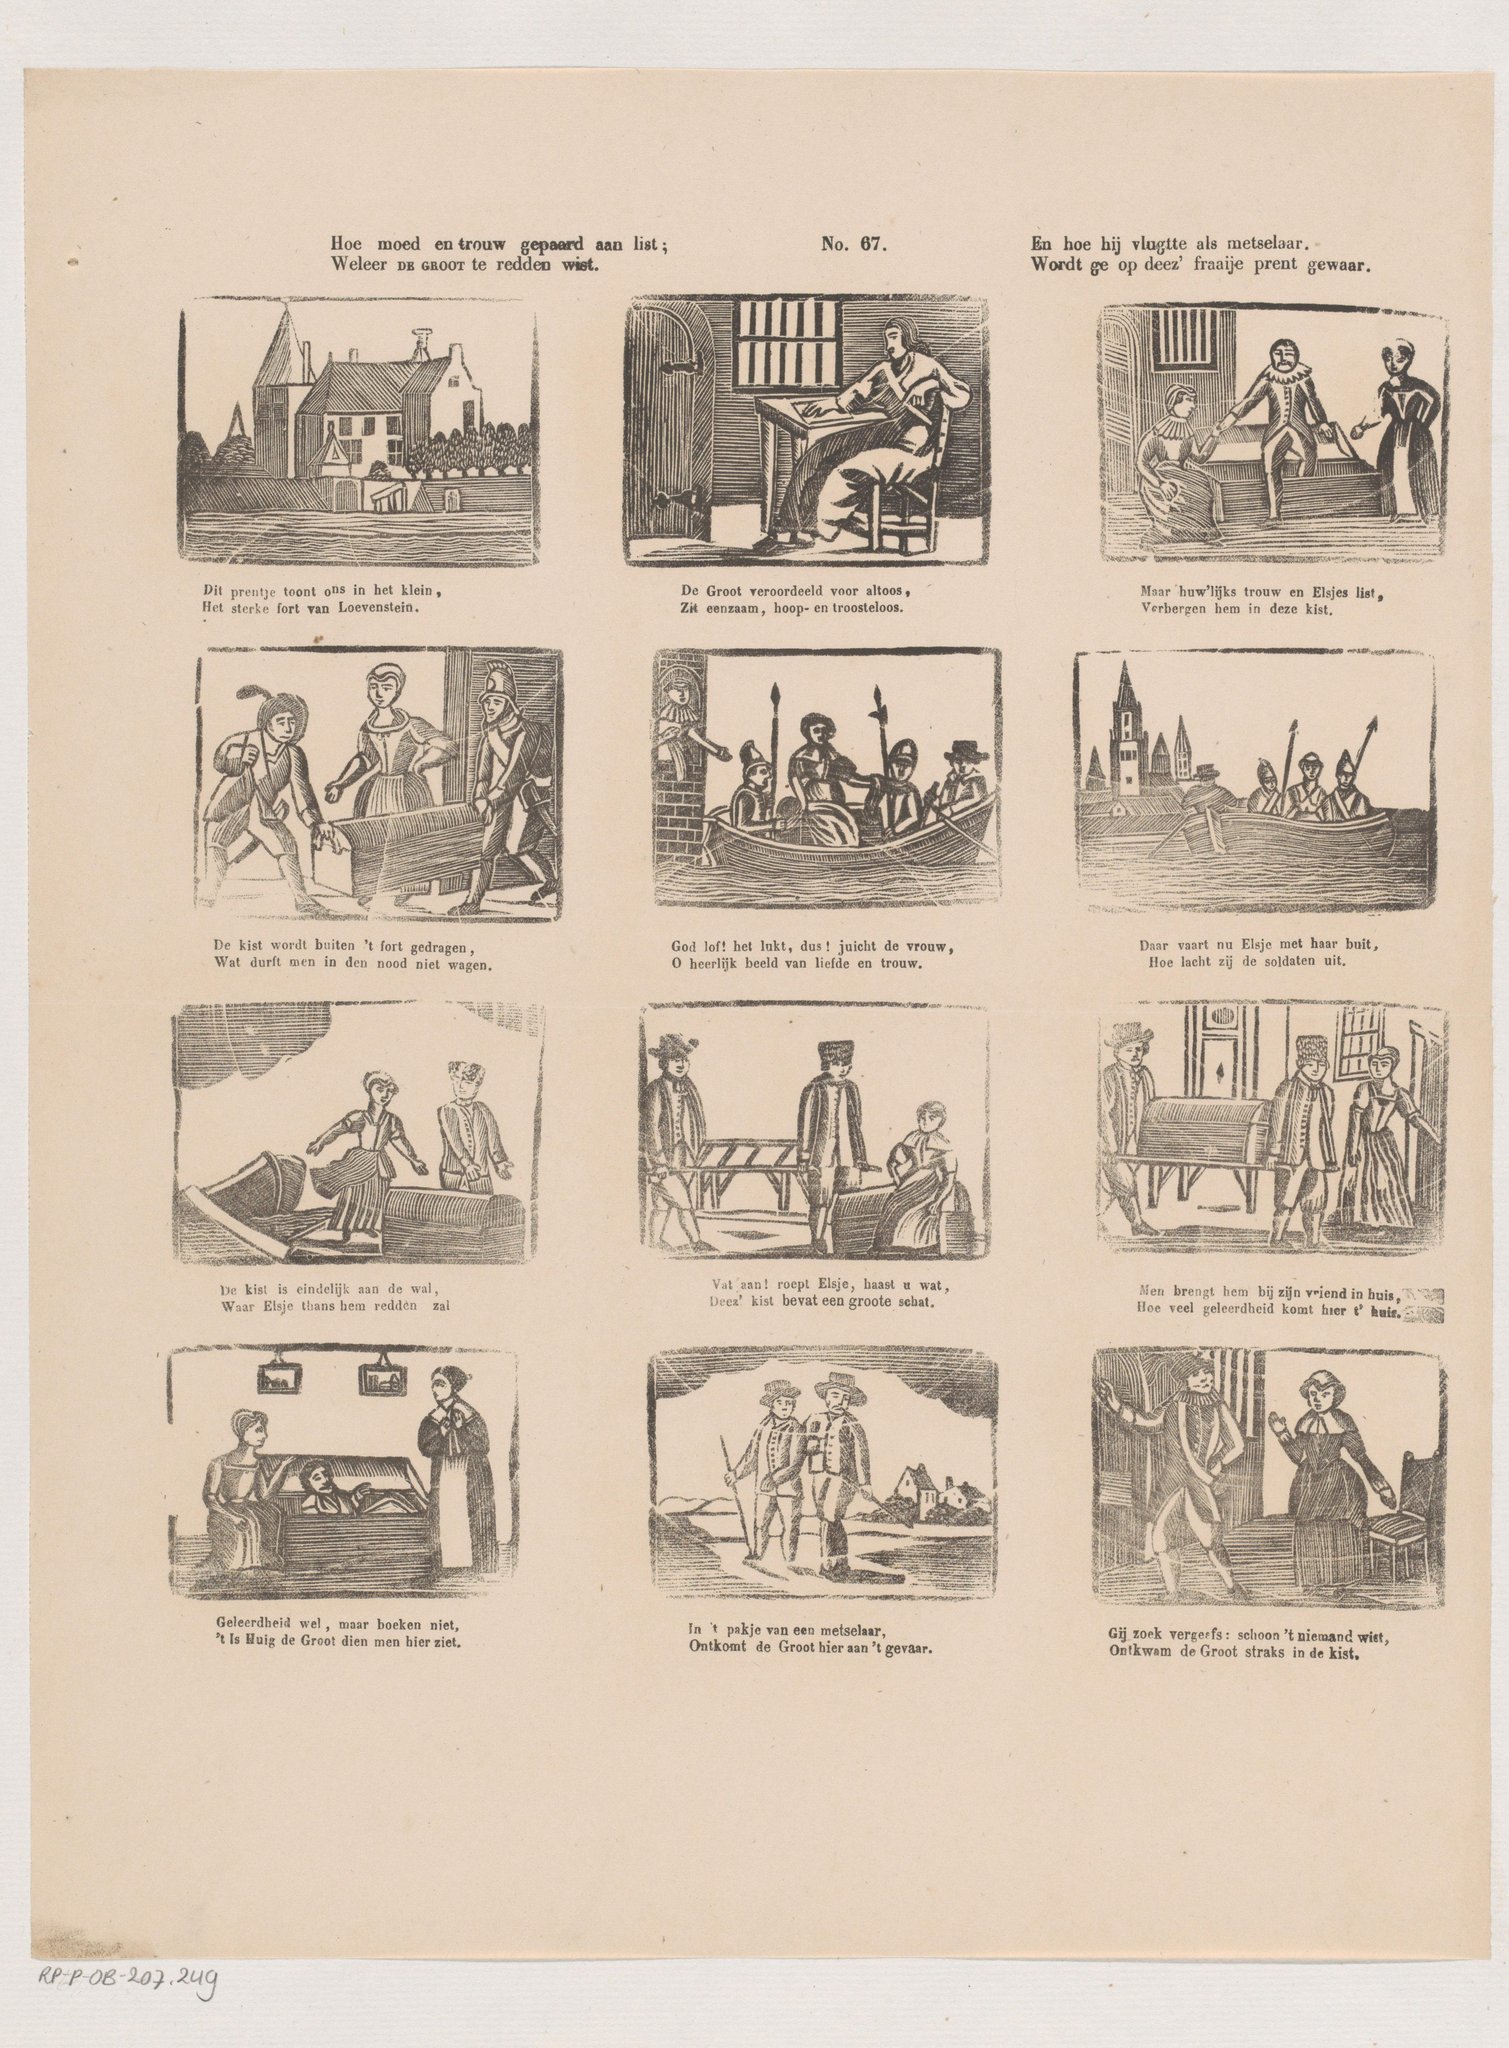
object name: print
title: Hoe moed en trouw gepaars aan list; / Weleer De Groot te redden wist. / En hoe hij vluchtte als metselaar. / Wordt ge op deez' fraaije prent gewaar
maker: Anonymous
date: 1848-1881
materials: paper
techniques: letterpress printing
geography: netherlands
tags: delft, hugo de groot, history, loevestein castle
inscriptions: collector's mark: Lugt 2760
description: Blad met 12 voorstellingen over de ontsnapping van Hugo de Groot uit Slot Loevestein verstopt in een boekenkist, op 22 maart 1621. Onder elke afbeelding een tweeregelig vers. Genummerd midden boven: No. 67.